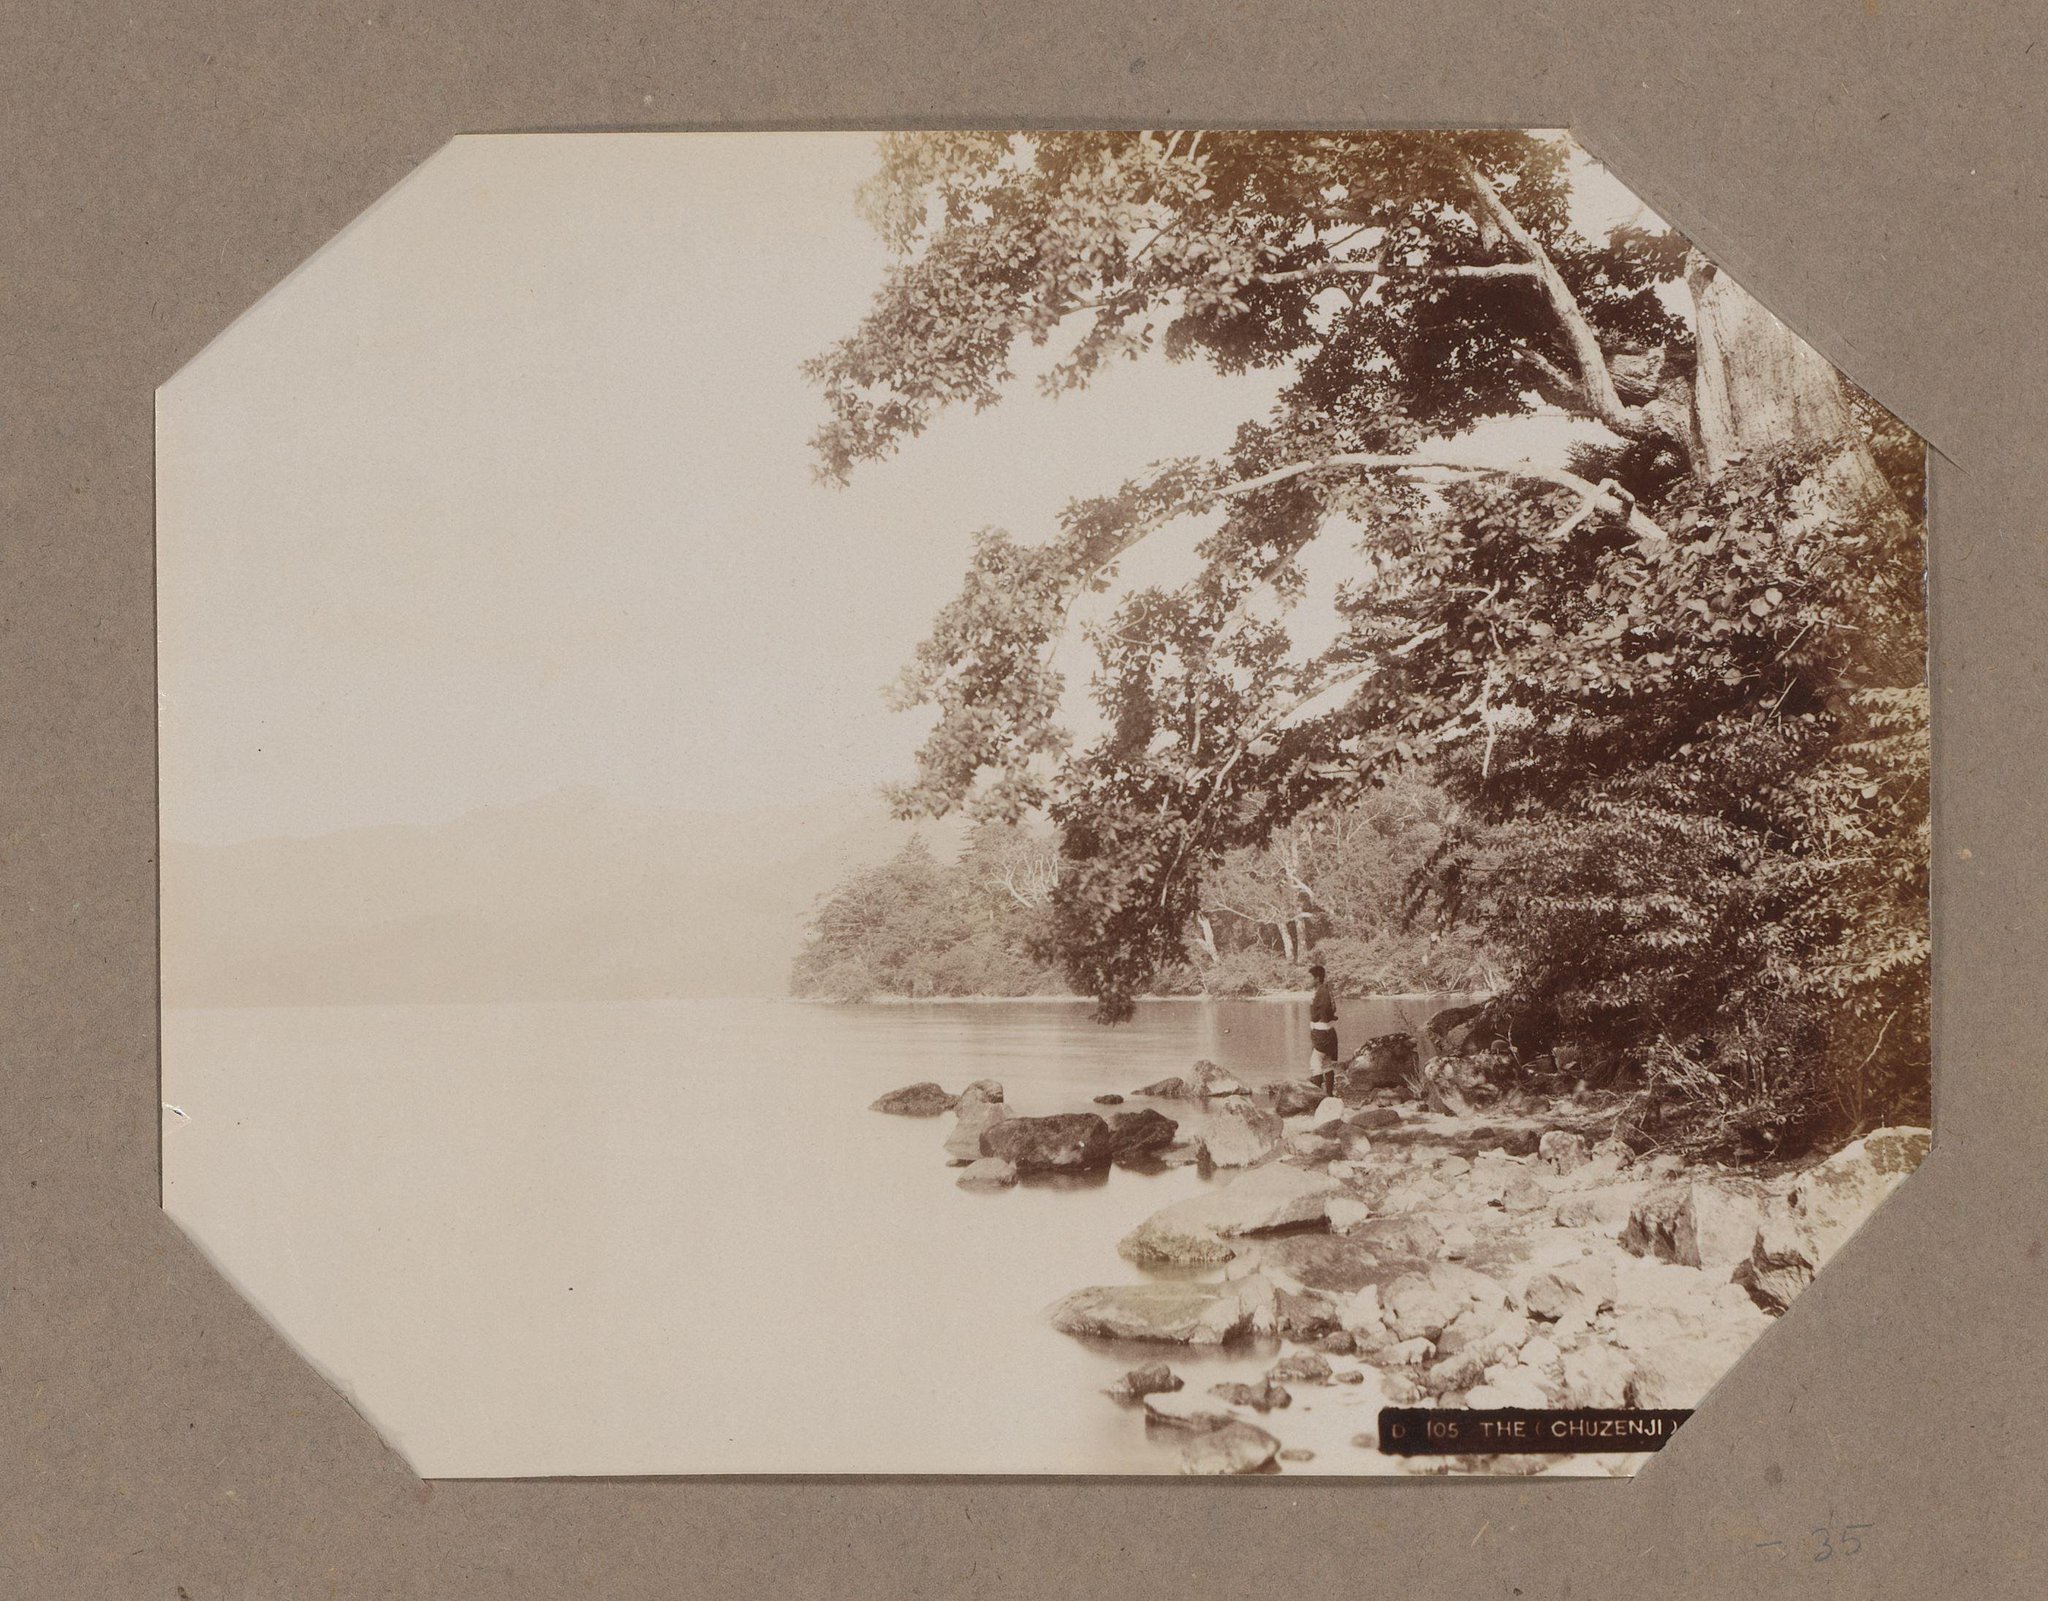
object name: album leaf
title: Gezicht op het Chozenji-ko meer bij Nikko, Japan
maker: Anonymous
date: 1890-1903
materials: paper, photographic support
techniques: albumen print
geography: japan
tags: lake (+ landscape with figures, staffage)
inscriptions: inscription: ‘D 105 The (Chuzenji) Lake at Nikko.’